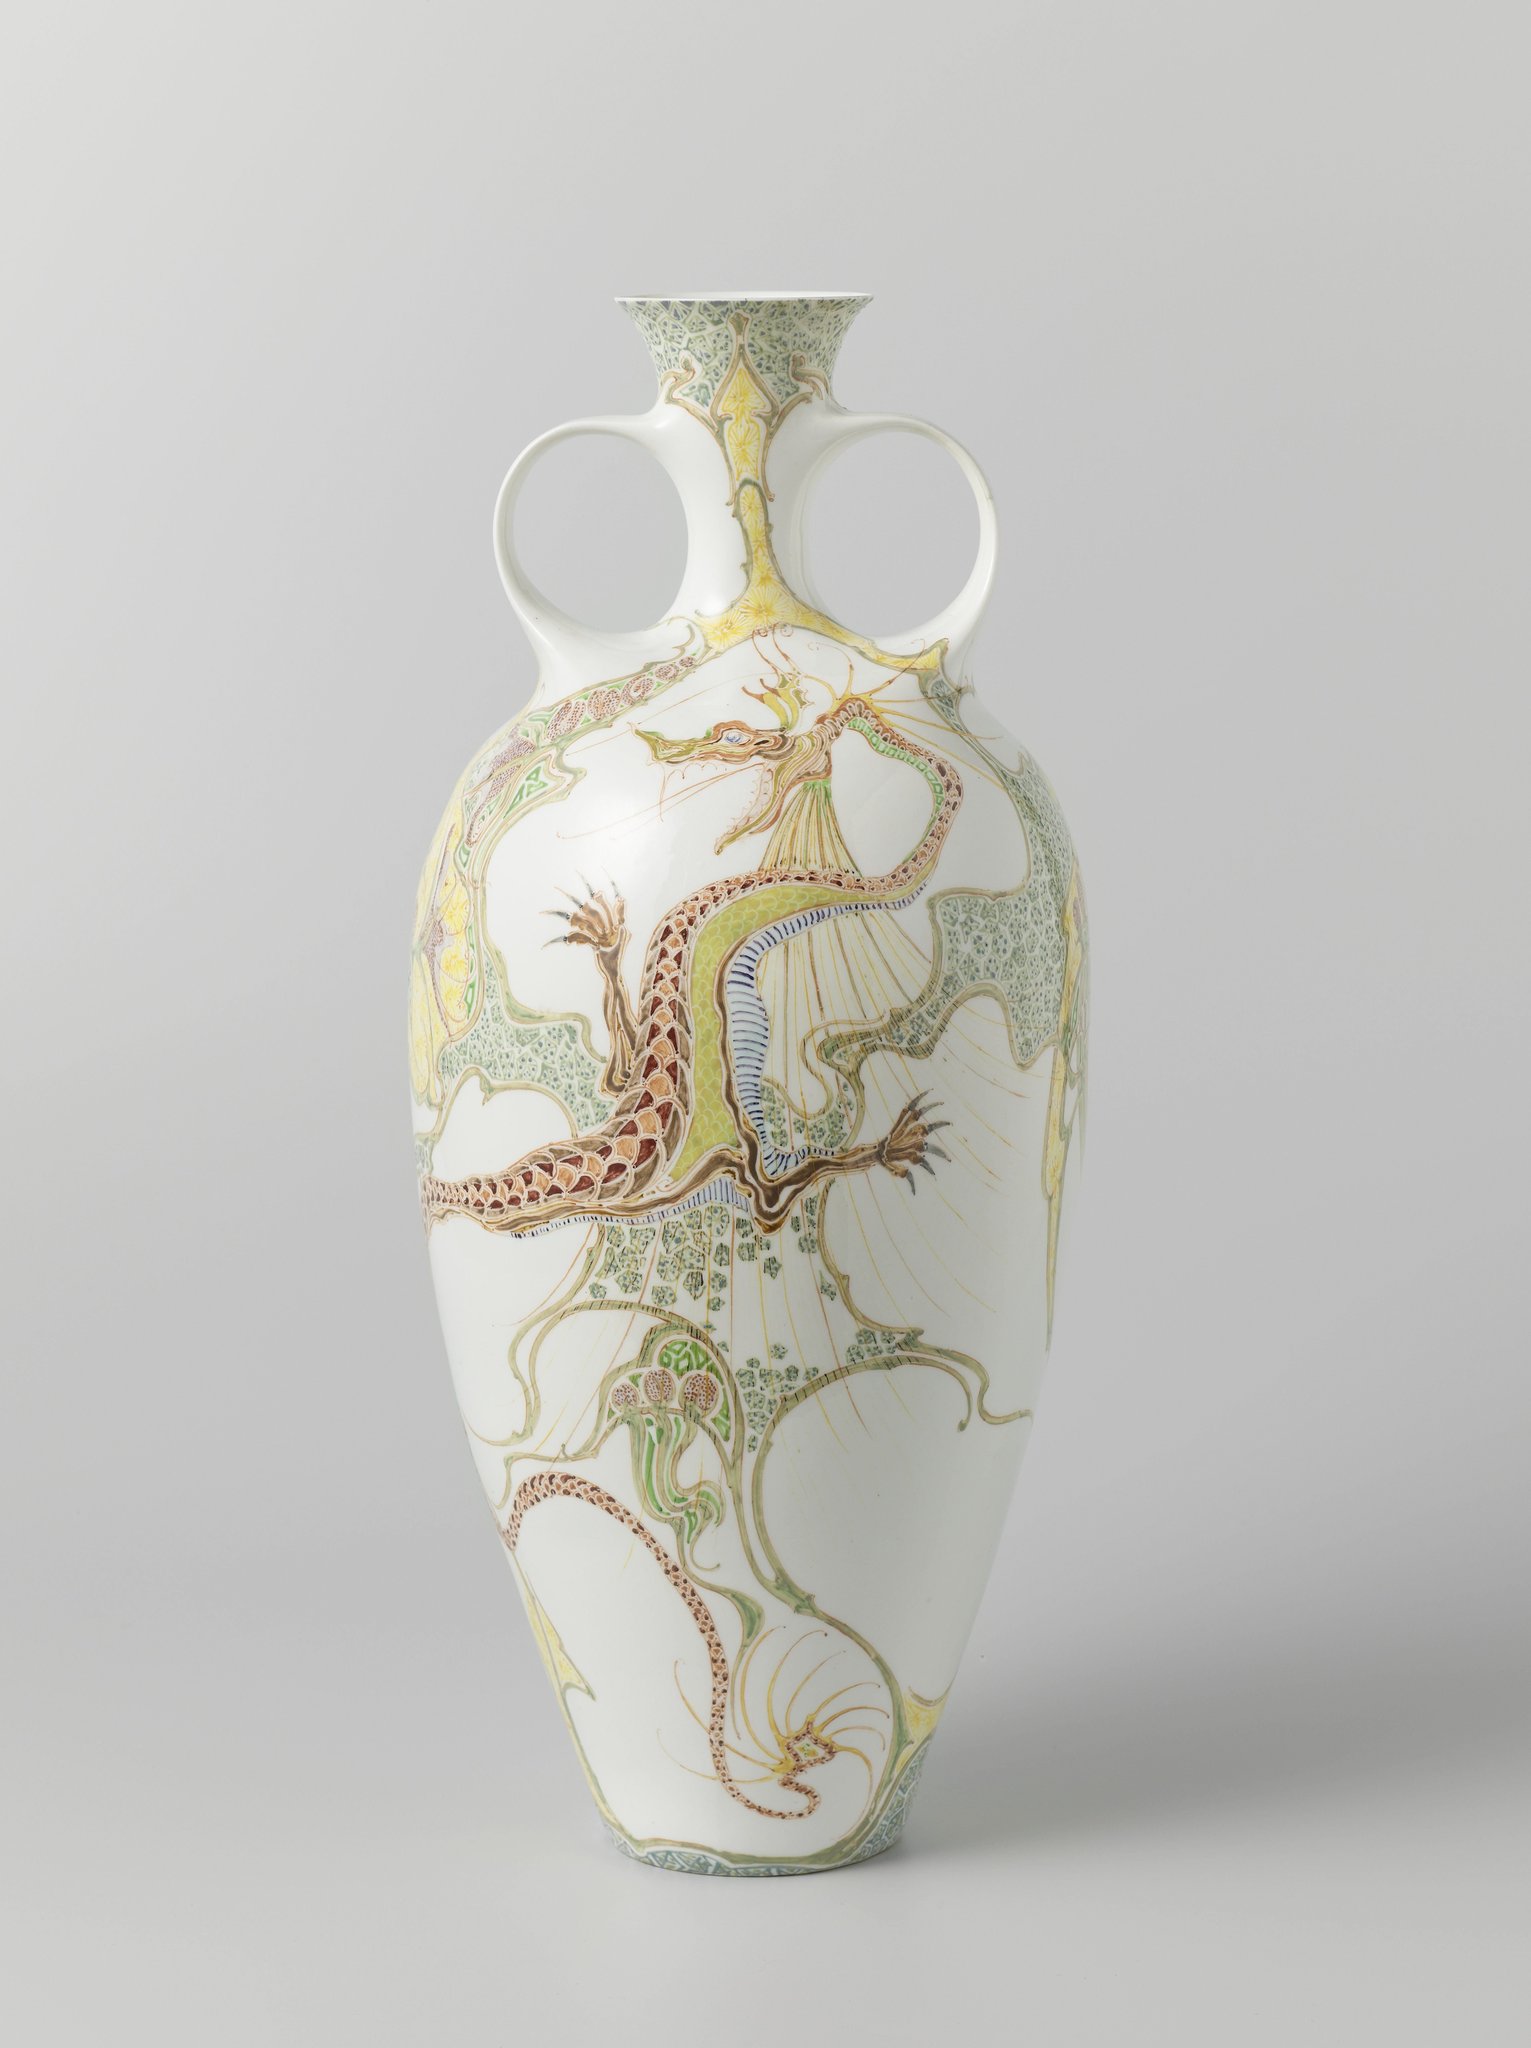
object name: vase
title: Vaas van porselein versierd met draak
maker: j.l. verhoog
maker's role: plateelschilder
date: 1900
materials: porcelain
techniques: firing, painted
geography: the hague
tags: dragon (large fabulous serpent, sometimes with wings and legs)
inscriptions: mark: ‘gestempeld in groen: Rozenburg/ooievaar/Den Haag; een bij (= 1900); rechts het werknummer 687; schildersmerk V; in relië modelnummer 108’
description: Vase, 1900, decorated by Jacobus L. Verhoog, model no 108.